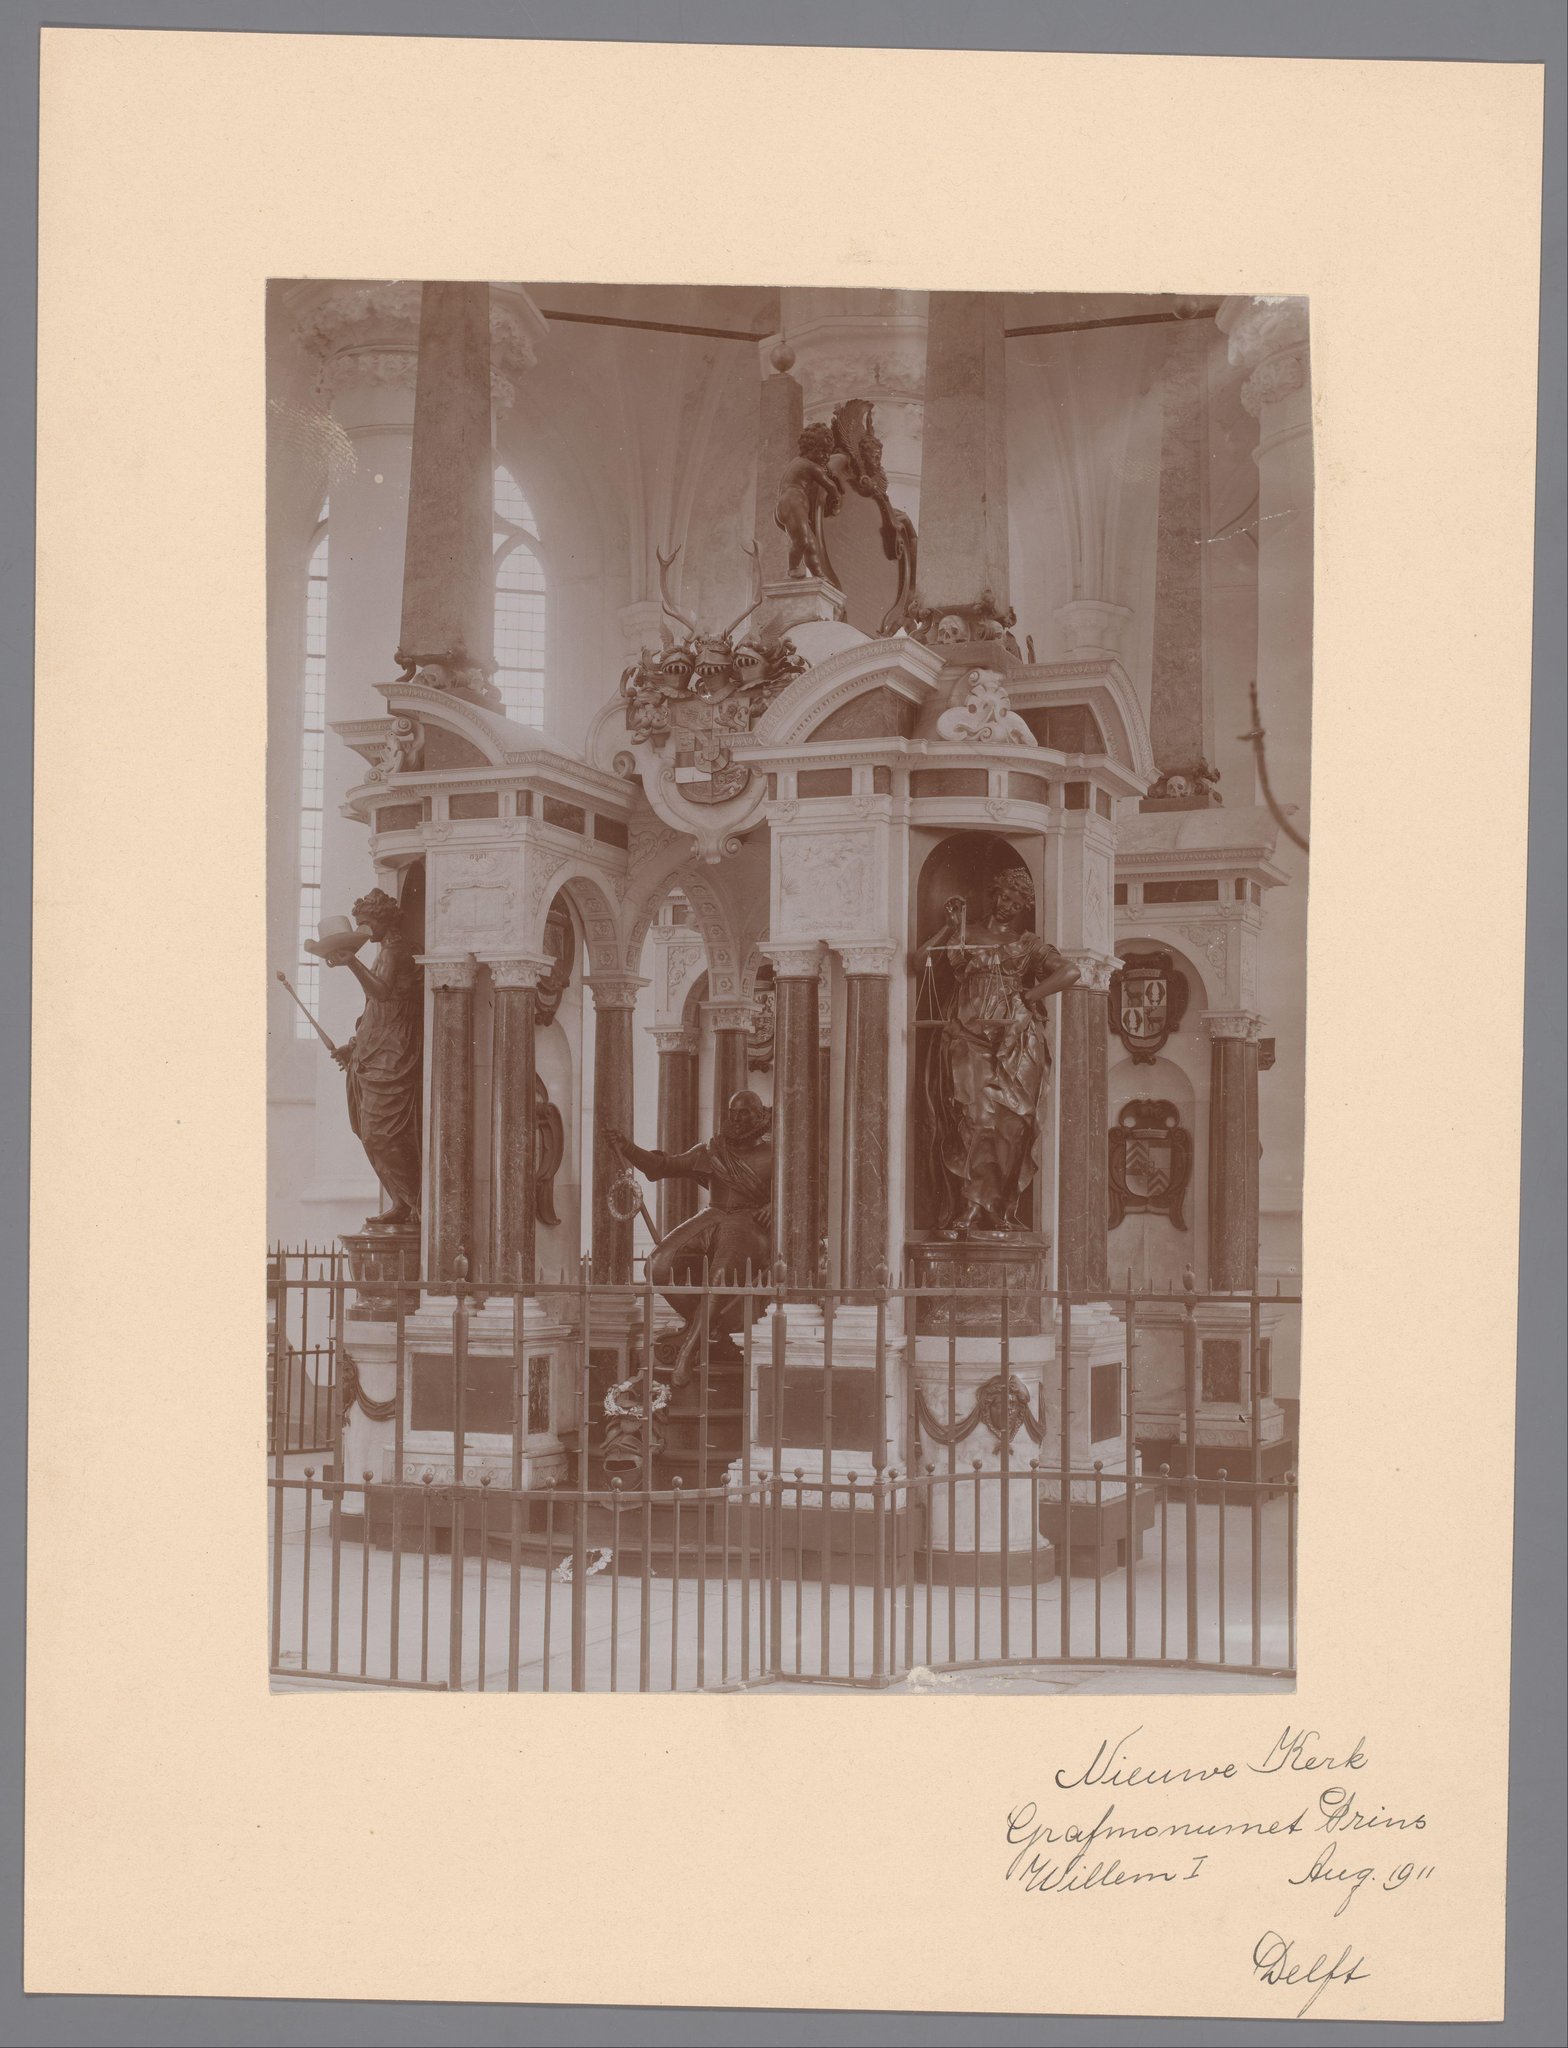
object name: photograph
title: Grafmonument van Willem I Frederik in de Nieuwe Kerk te Delft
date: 1911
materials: cardboard, photographic support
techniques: collodion silver print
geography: nieuwe kerk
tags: william i (prince of orange), interior of church, grave-building, monumental tomb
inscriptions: annotation, annotation: ‘Nieuwe Kerk/ grafmonument prins Willem I/ Aug. 1911/ Delft’